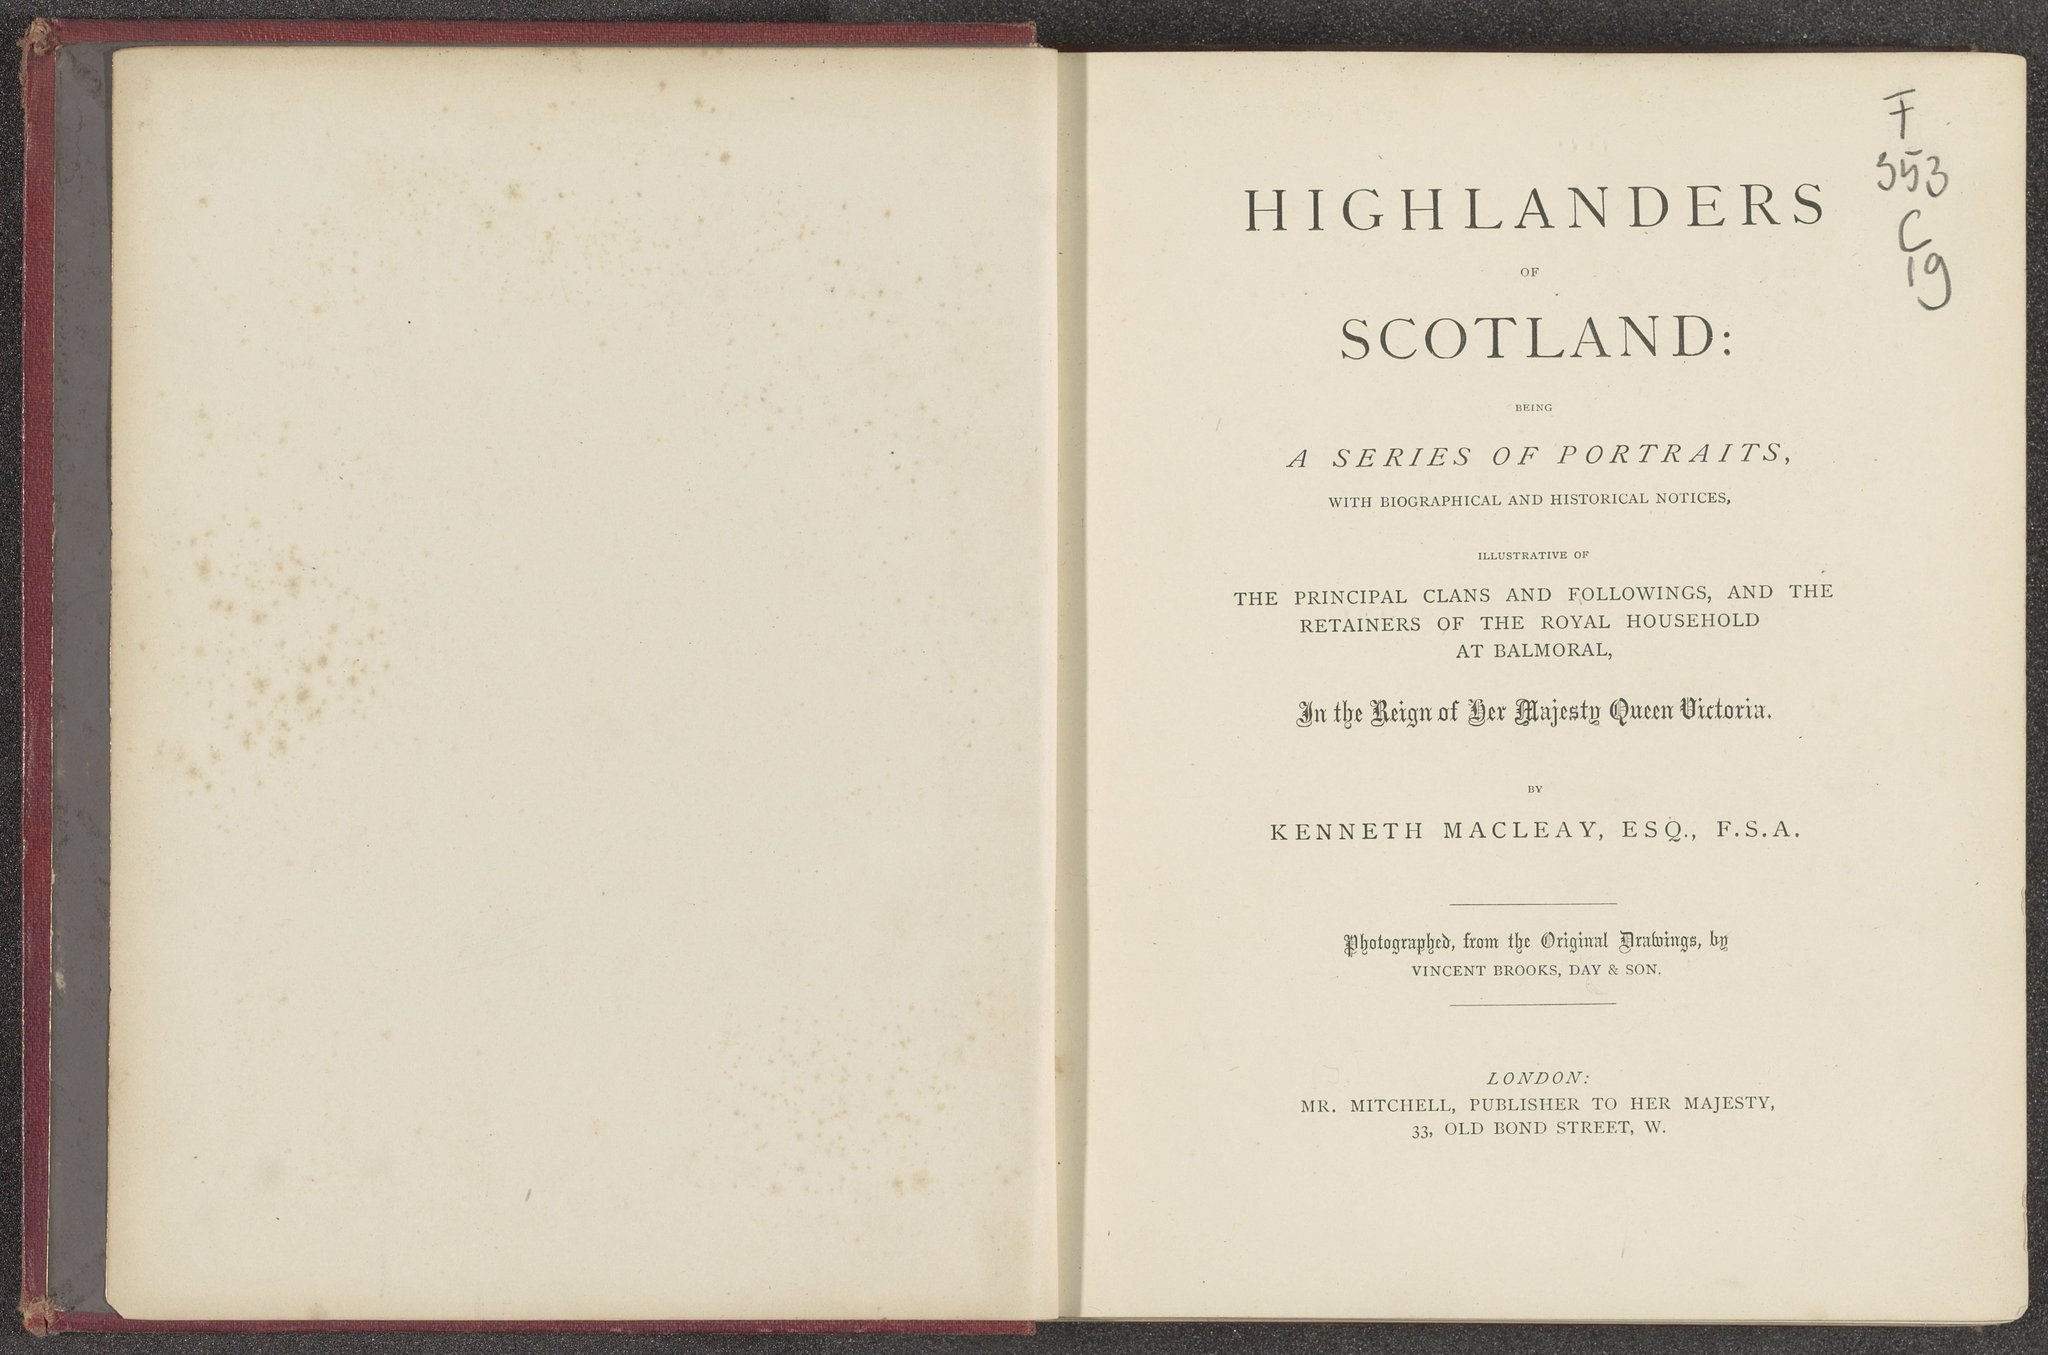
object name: book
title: Highlanders of Scotland being a series of portraits, with biographical and historical notices illustrative of the principal clans and followings, and the retainers of the royal household at Balmoral in the reign of Her Majesty Queen Victoria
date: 1870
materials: paper, photographic support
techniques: albumen print, hand coloring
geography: london